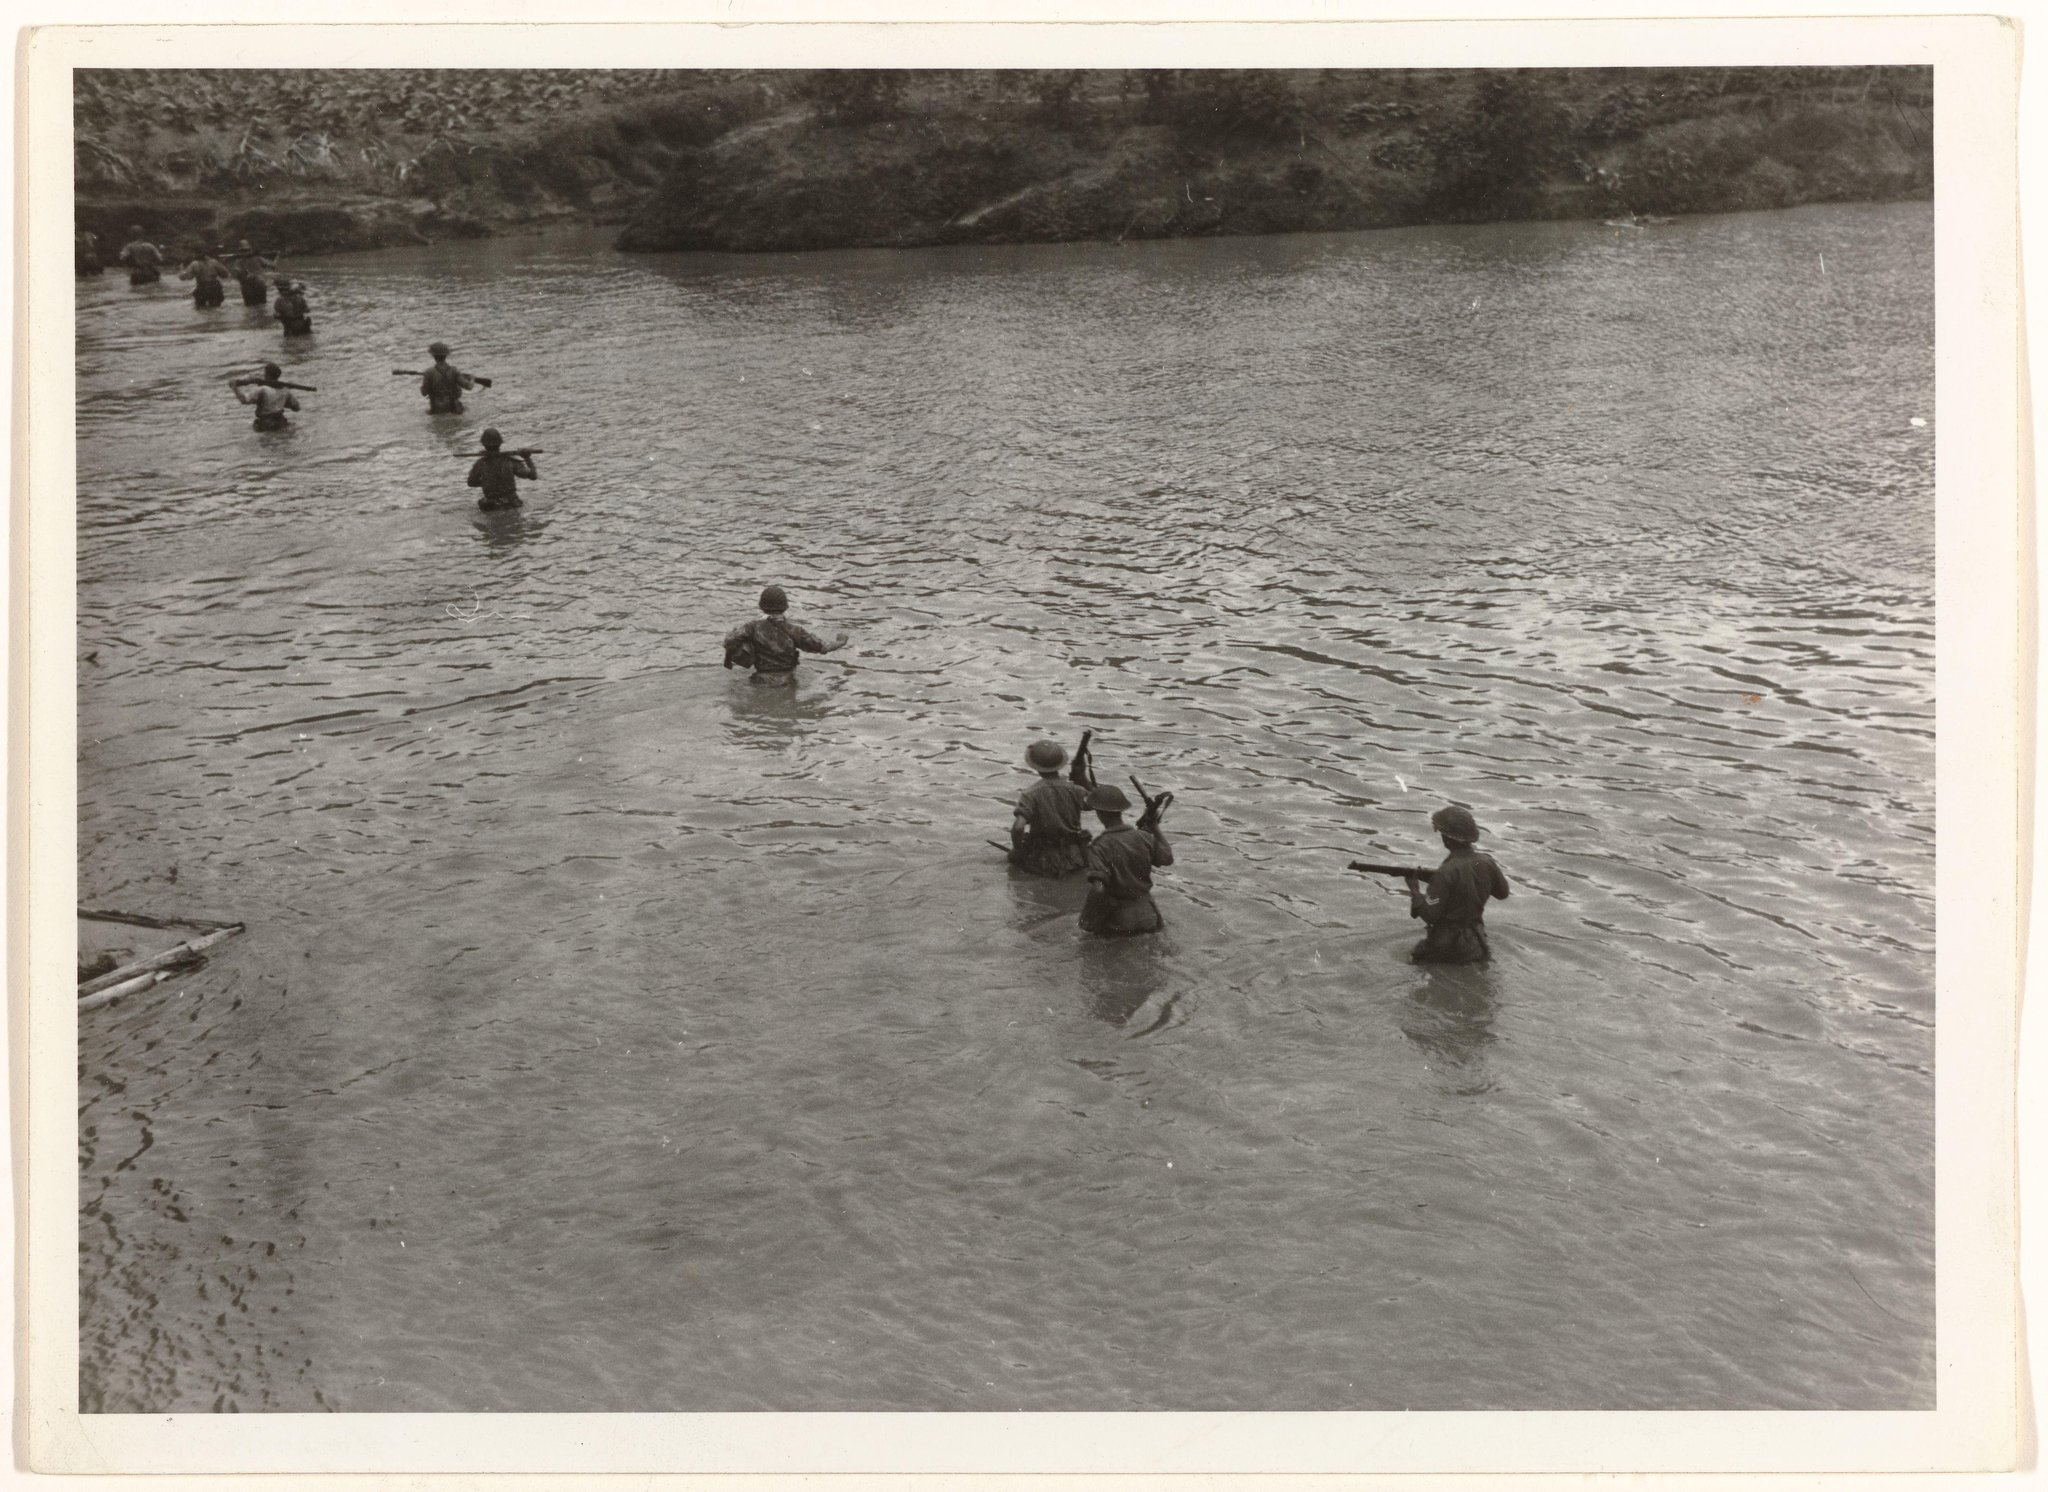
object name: photograph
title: Opmars naar Tjilatap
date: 1947-1949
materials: photographic support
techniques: photography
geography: java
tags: troop movements, transportation, java, dutch east indies, the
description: Opmars naar Tjilatap. Nederlandse infanteristen waden door een rivier om het terrein aan de overzijde te beveiligen.